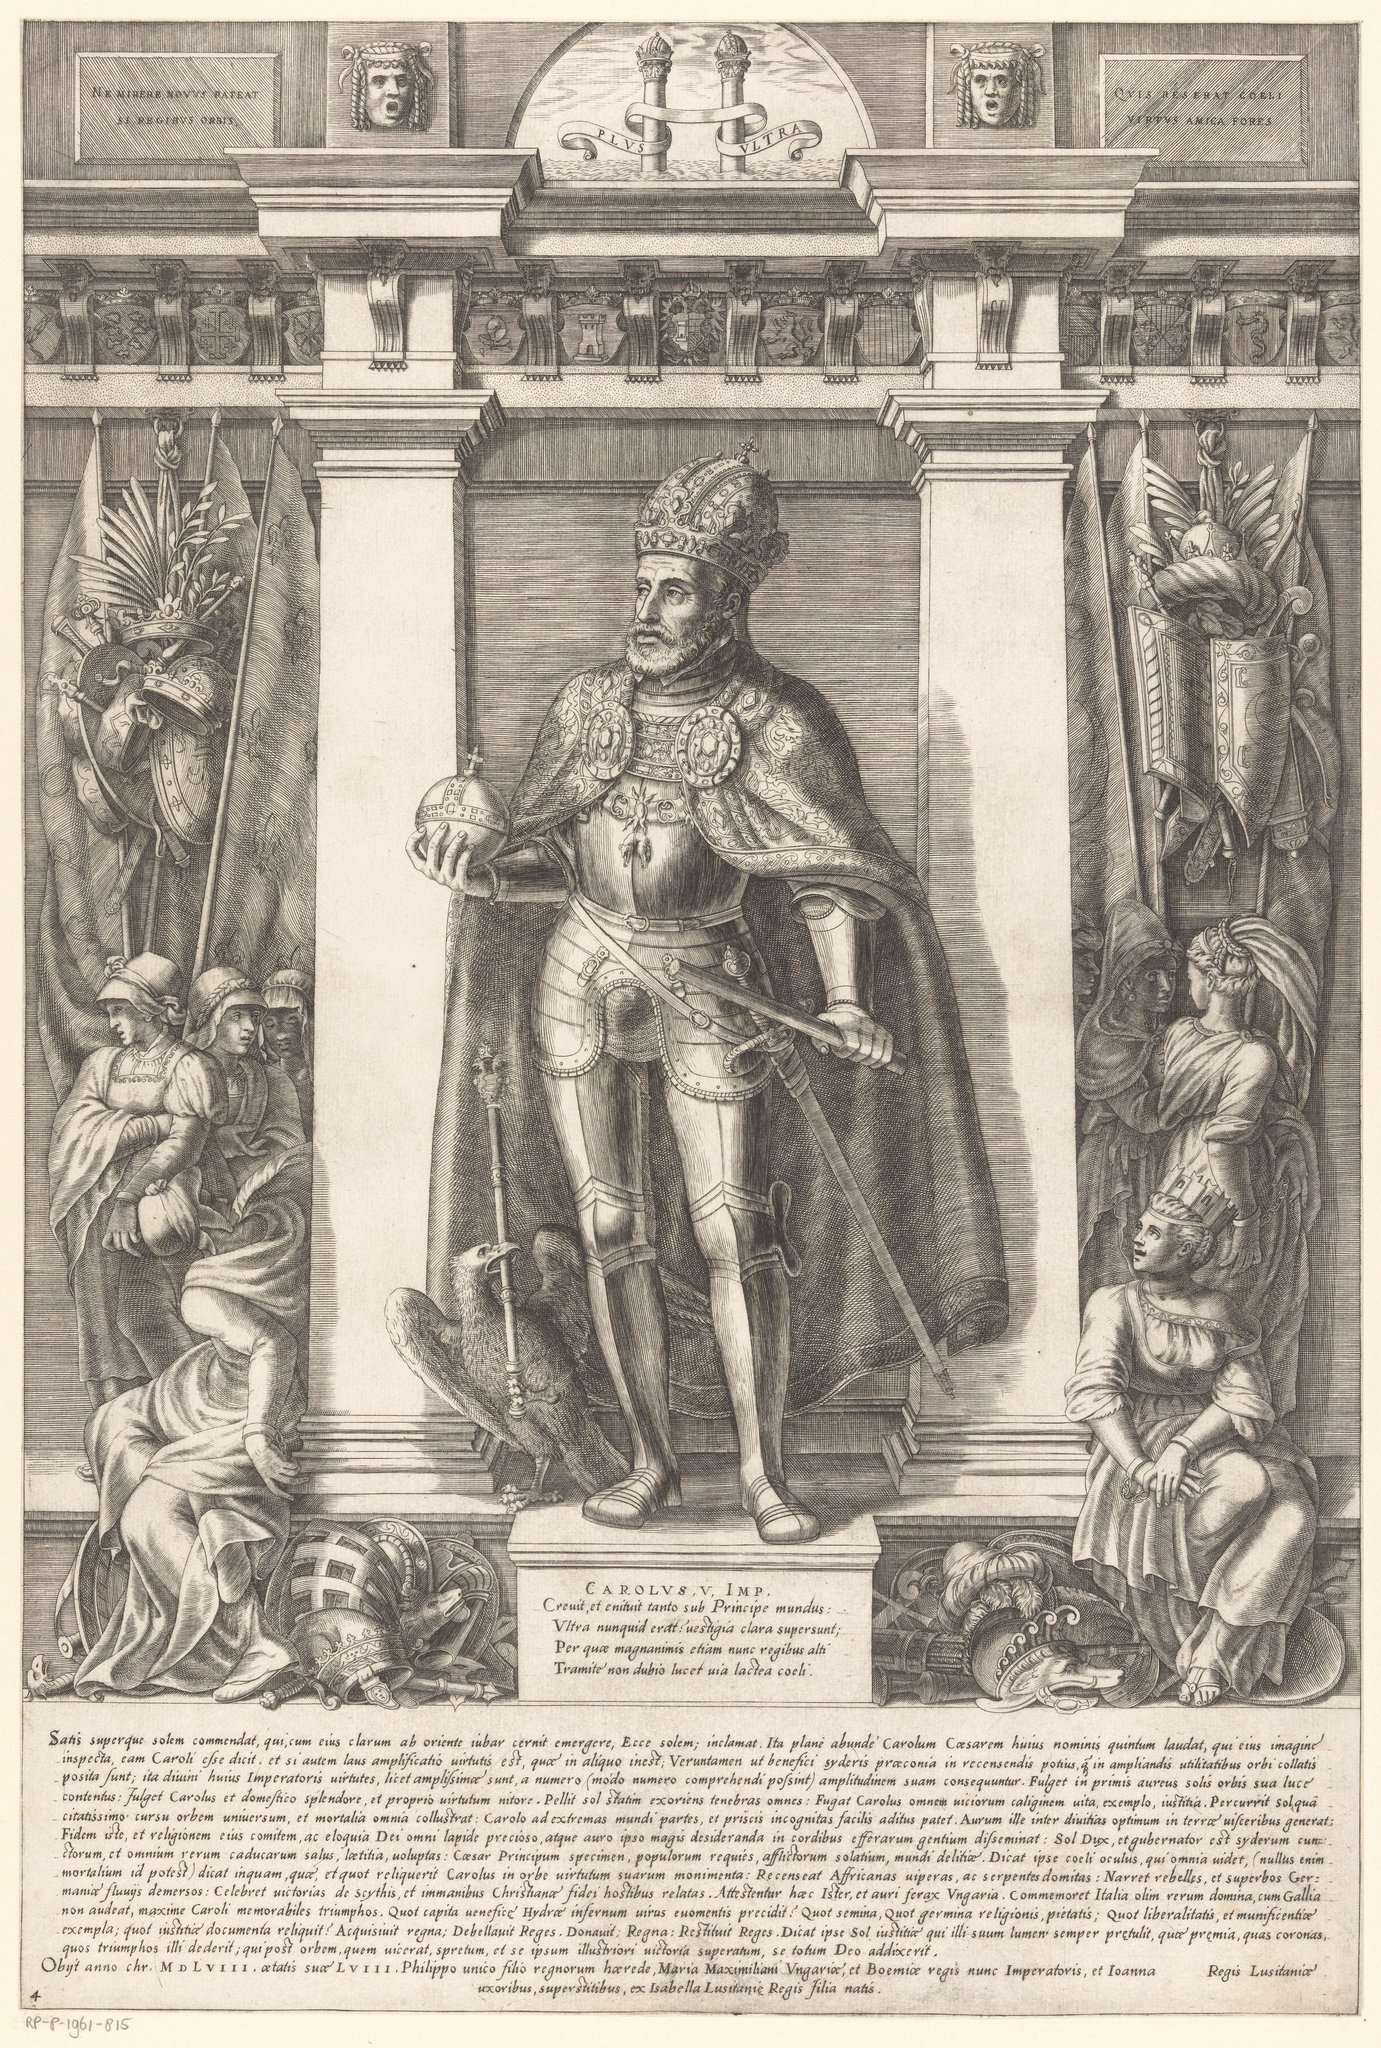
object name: print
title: Austriacae gentis imaginum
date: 1569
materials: paper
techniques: engraving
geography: italy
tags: ghent, charles v (holy roman emperor and king of spain), historical persons, ruler, sovereign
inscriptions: collector's mark: Lugt 2228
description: Deze prent maakt deel uit van een reeks van 58 prenten. Het meerendeel van de prenten bevat portretten van 74 leden van het Oostenrijkse Huis, naar tekeningen door Francesco Terzio, die deels getekend zijn naar de 28 levensgrote bronzen beelden die rond de cenotaaf van Maximiliaan I in de Hofkirche te Innsbruck staan.